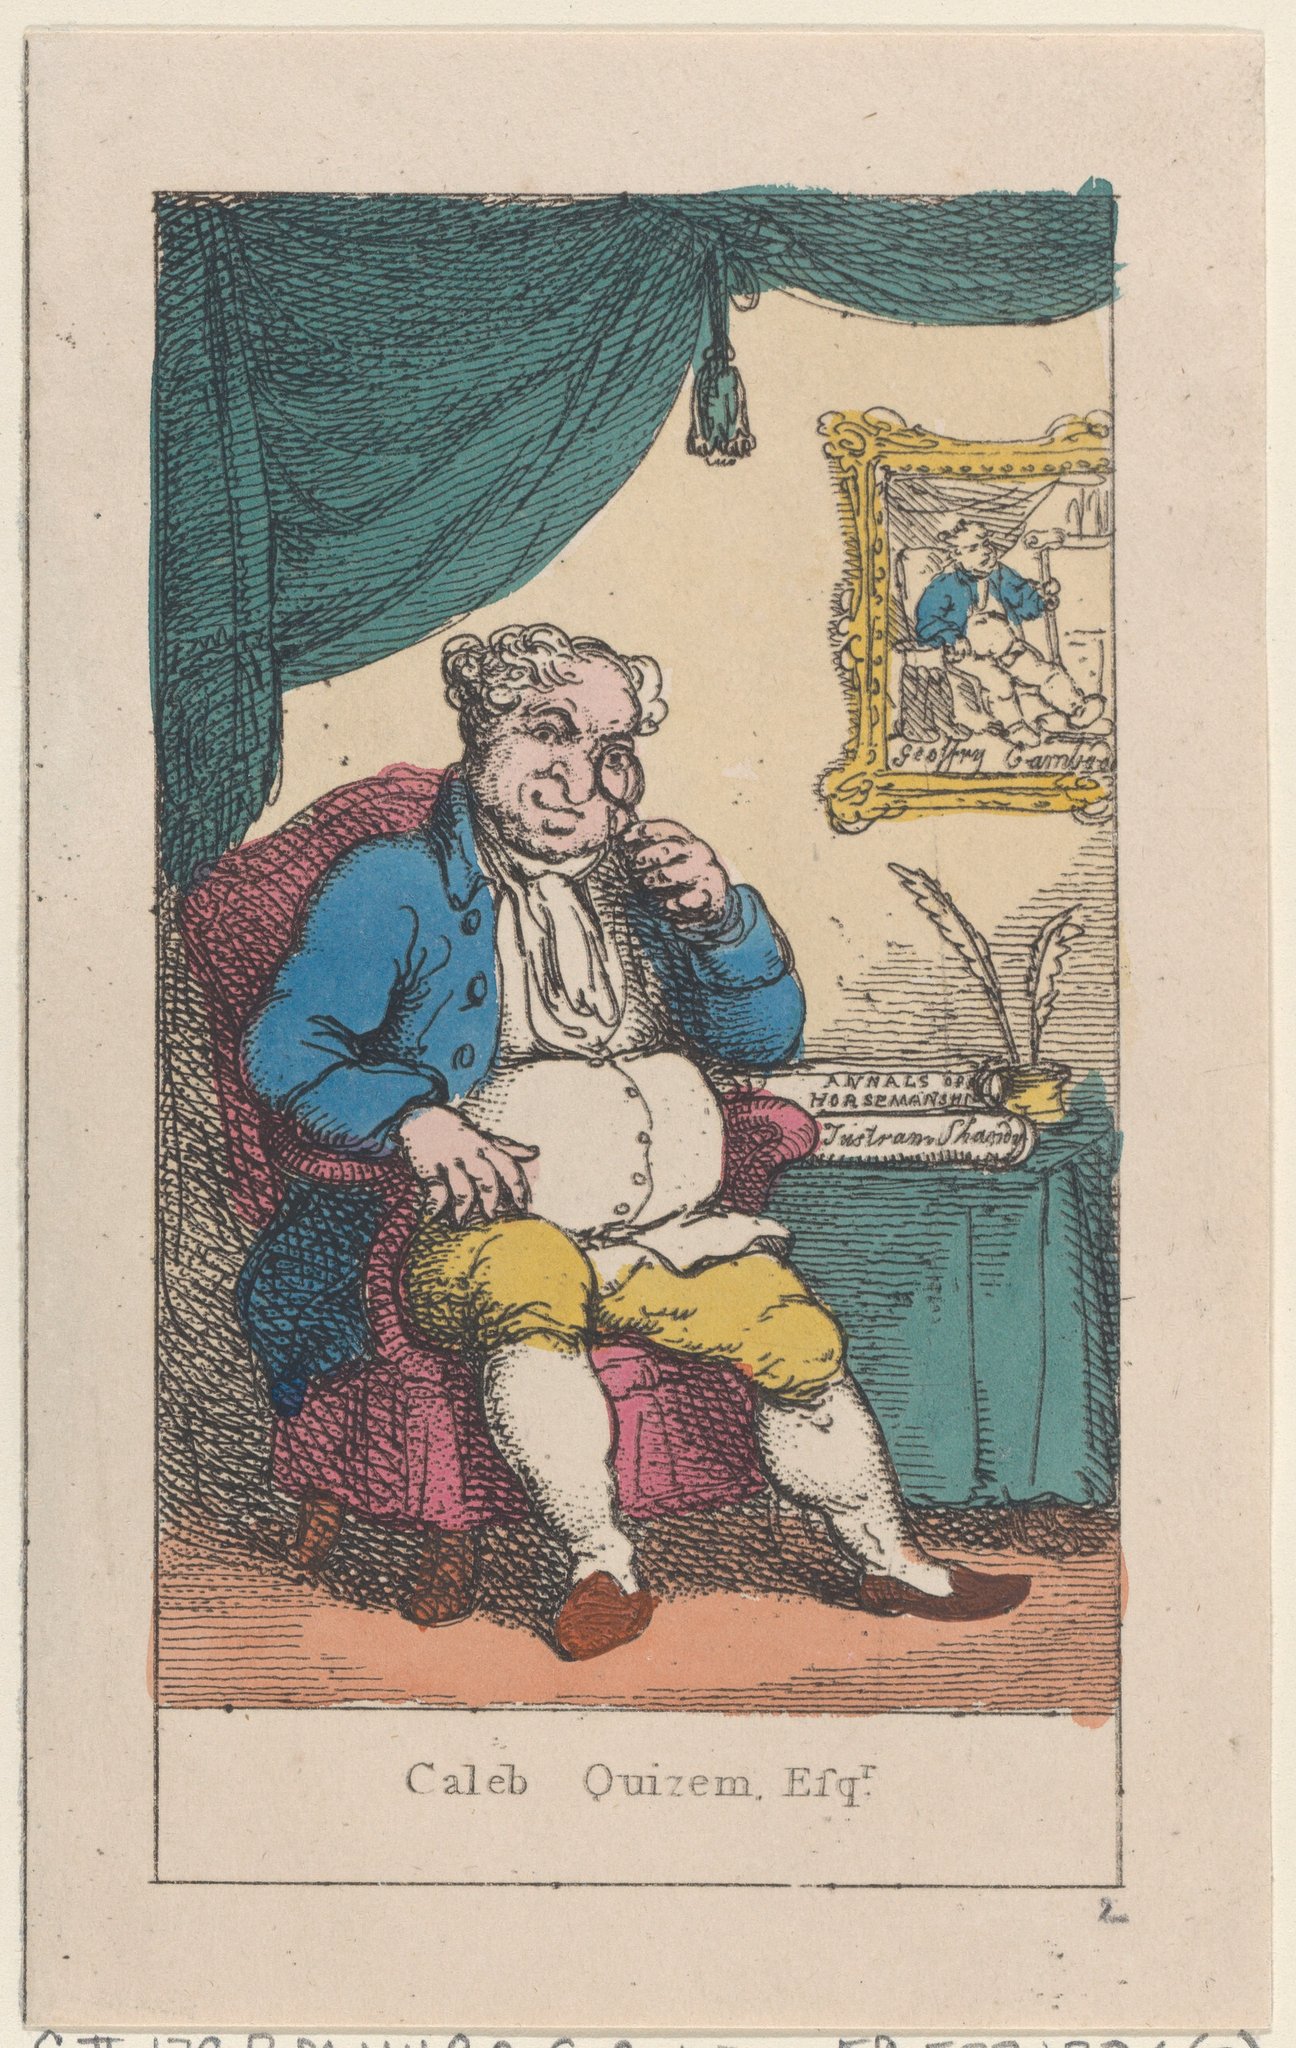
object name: print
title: Portrait of Caleb Quizem, Esq.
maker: thomas rowlandson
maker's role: artist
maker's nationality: british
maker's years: 1757-1827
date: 1809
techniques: etching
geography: london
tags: men,caricature